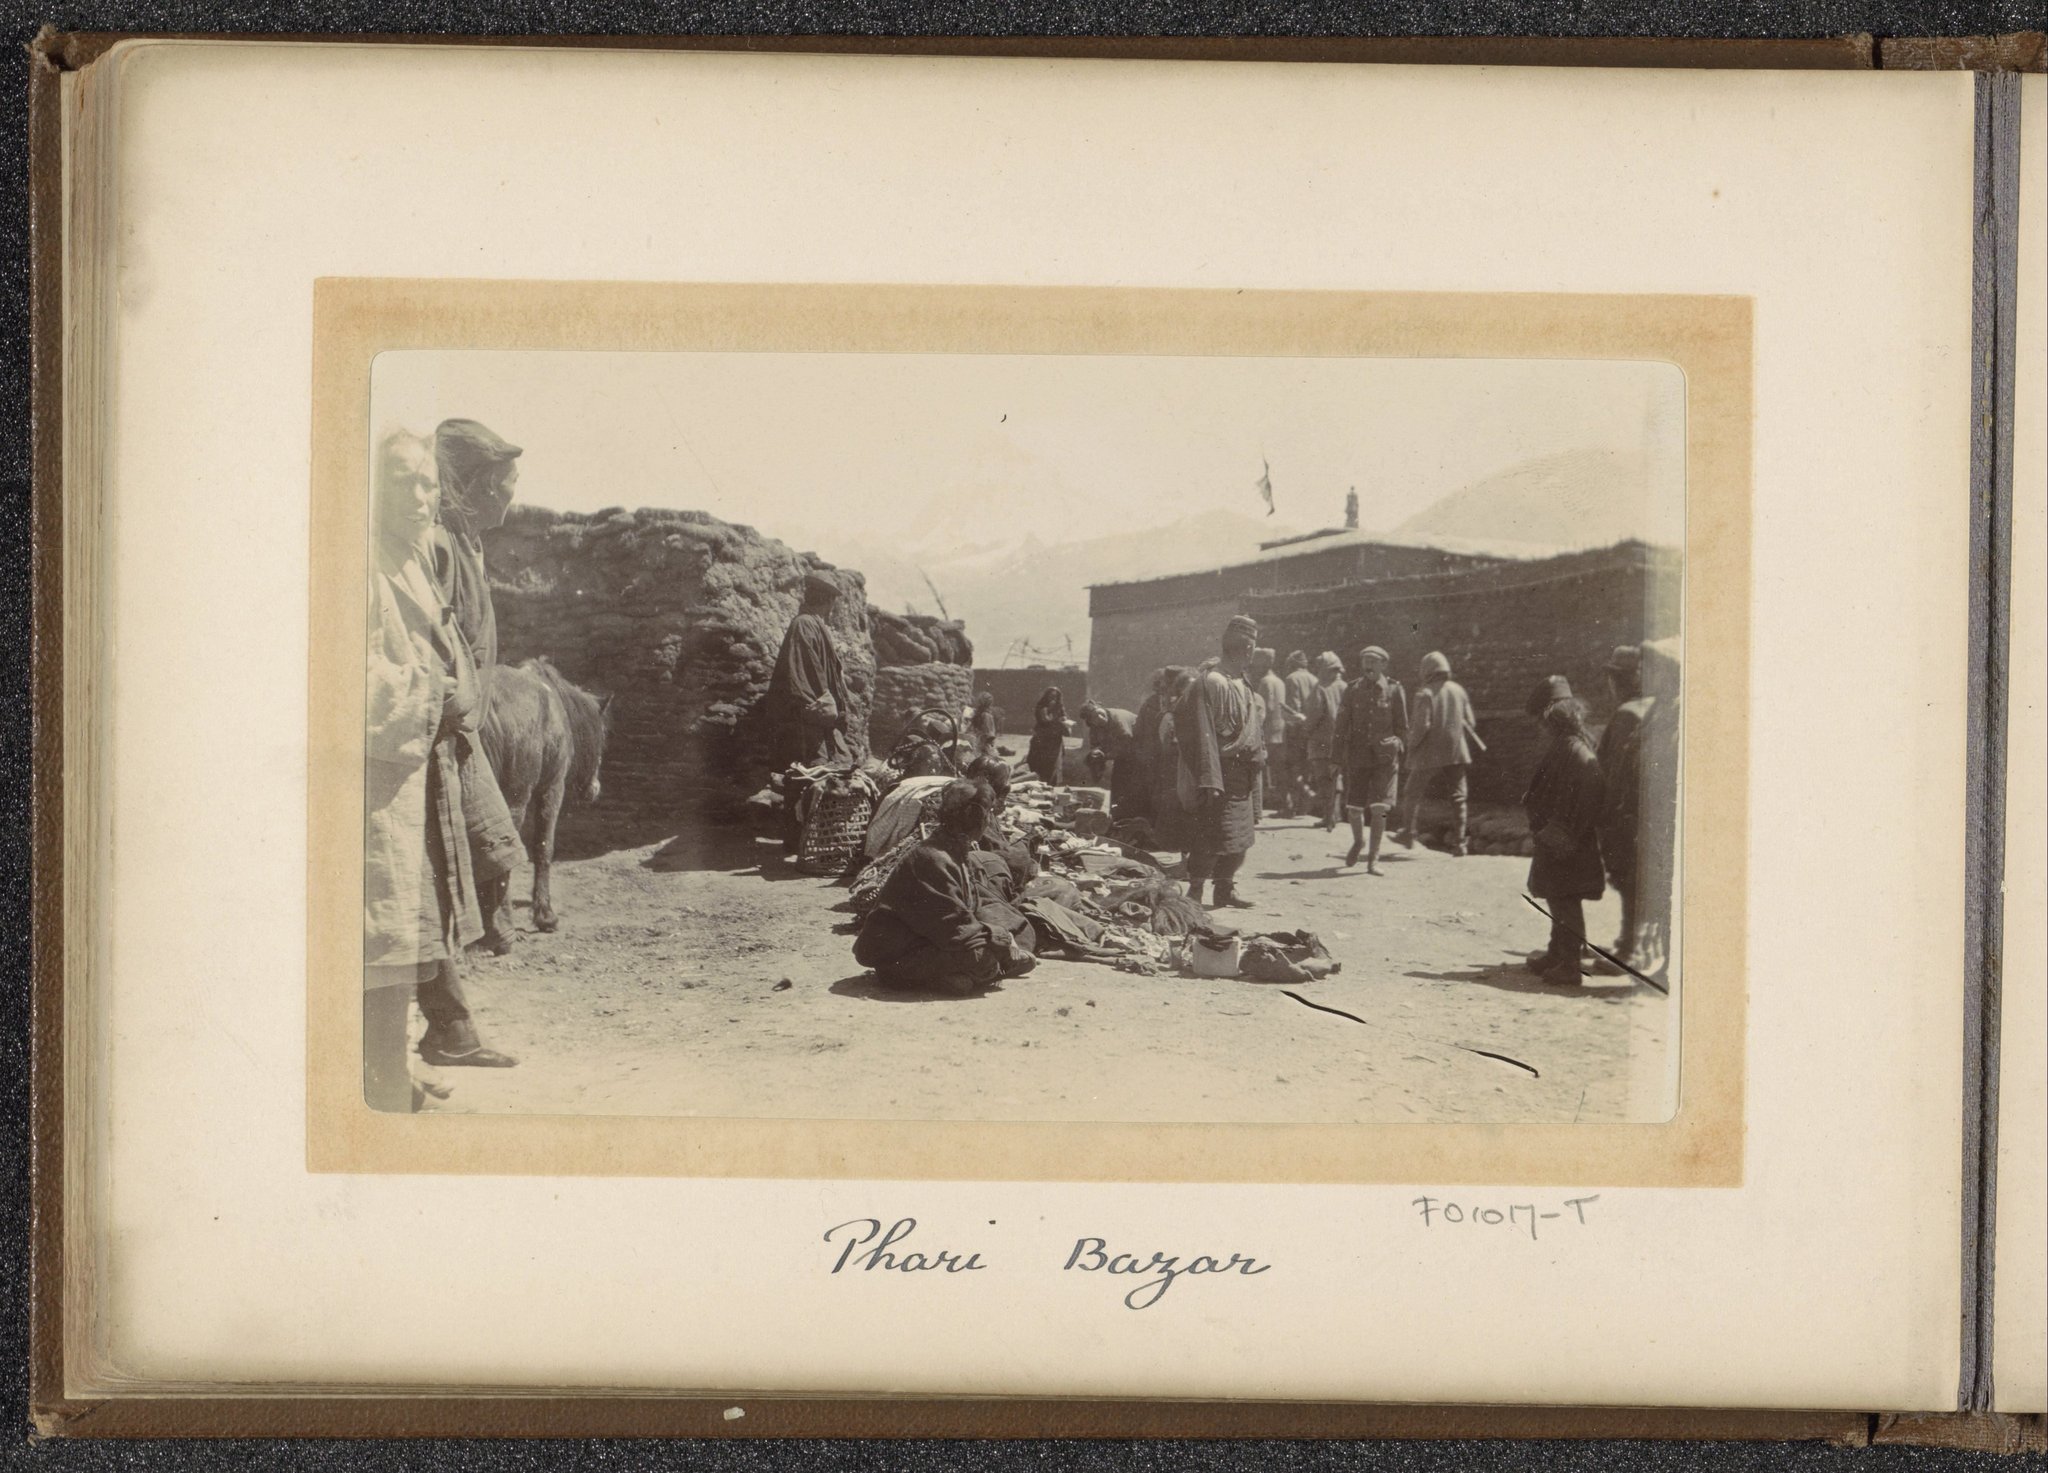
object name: photograph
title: Market in Phari town, Tibet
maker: d.t. dalton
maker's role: sergeant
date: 1903-1906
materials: photographic support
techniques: gelatin silver print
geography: phari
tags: buying and selling, market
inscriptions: title: ‘Phari Bazar’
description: Onderdeel van Fotoalbum met 24 foto's van de reis van legertelegrafist D.T. Dalton door Tibet.